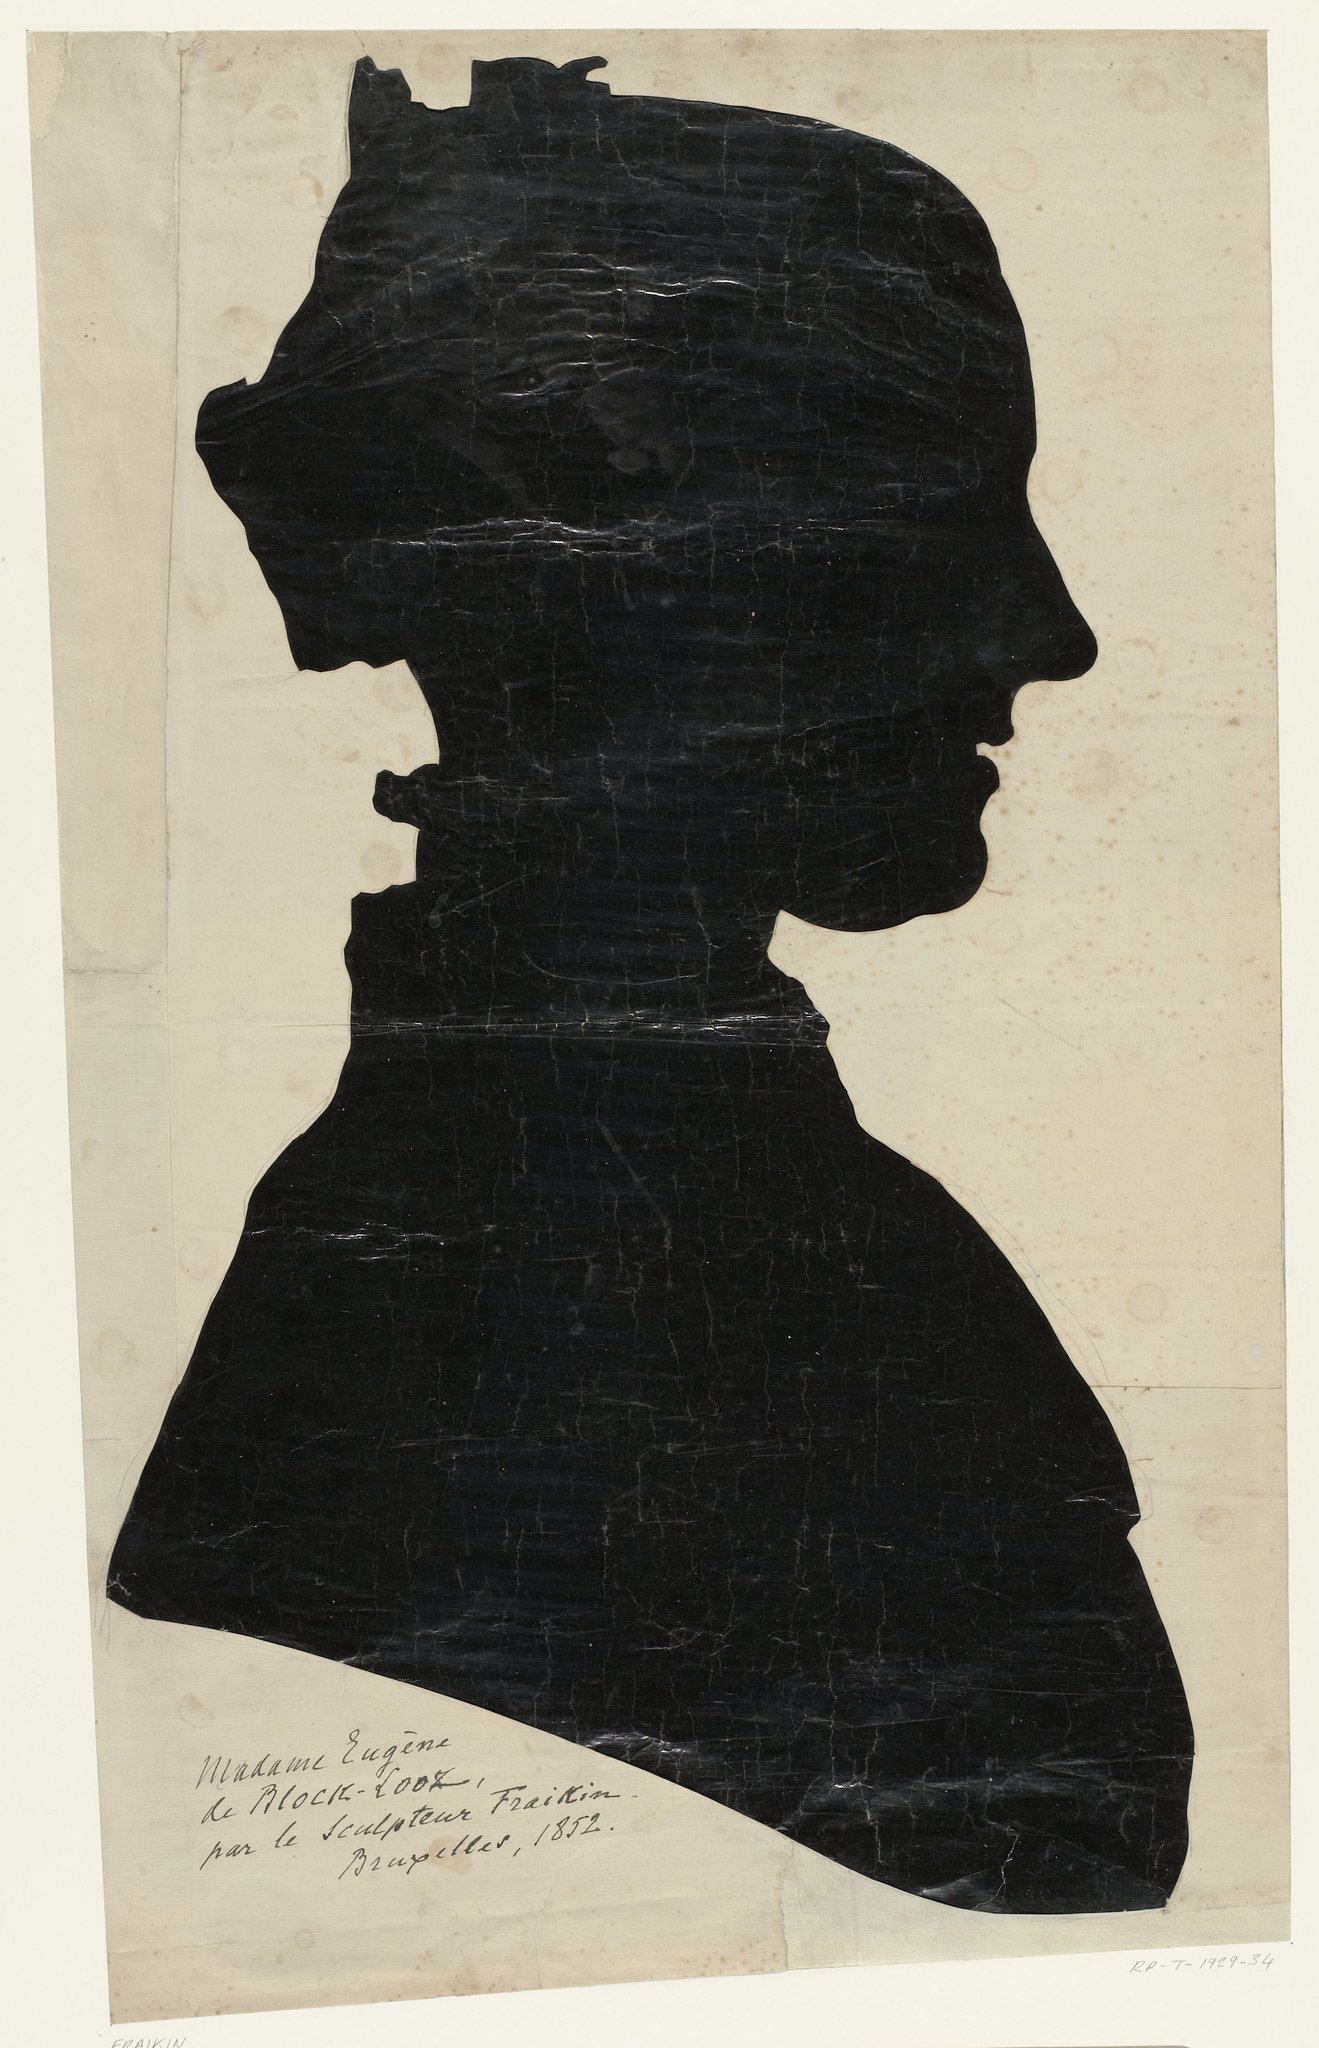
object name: drawing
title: Silhouet van Madame Eugène de Block-Looz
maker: charles auguste fraikin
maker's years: 1817-1893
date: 1852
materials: paper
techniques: snipping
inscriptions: date: ‘1852’